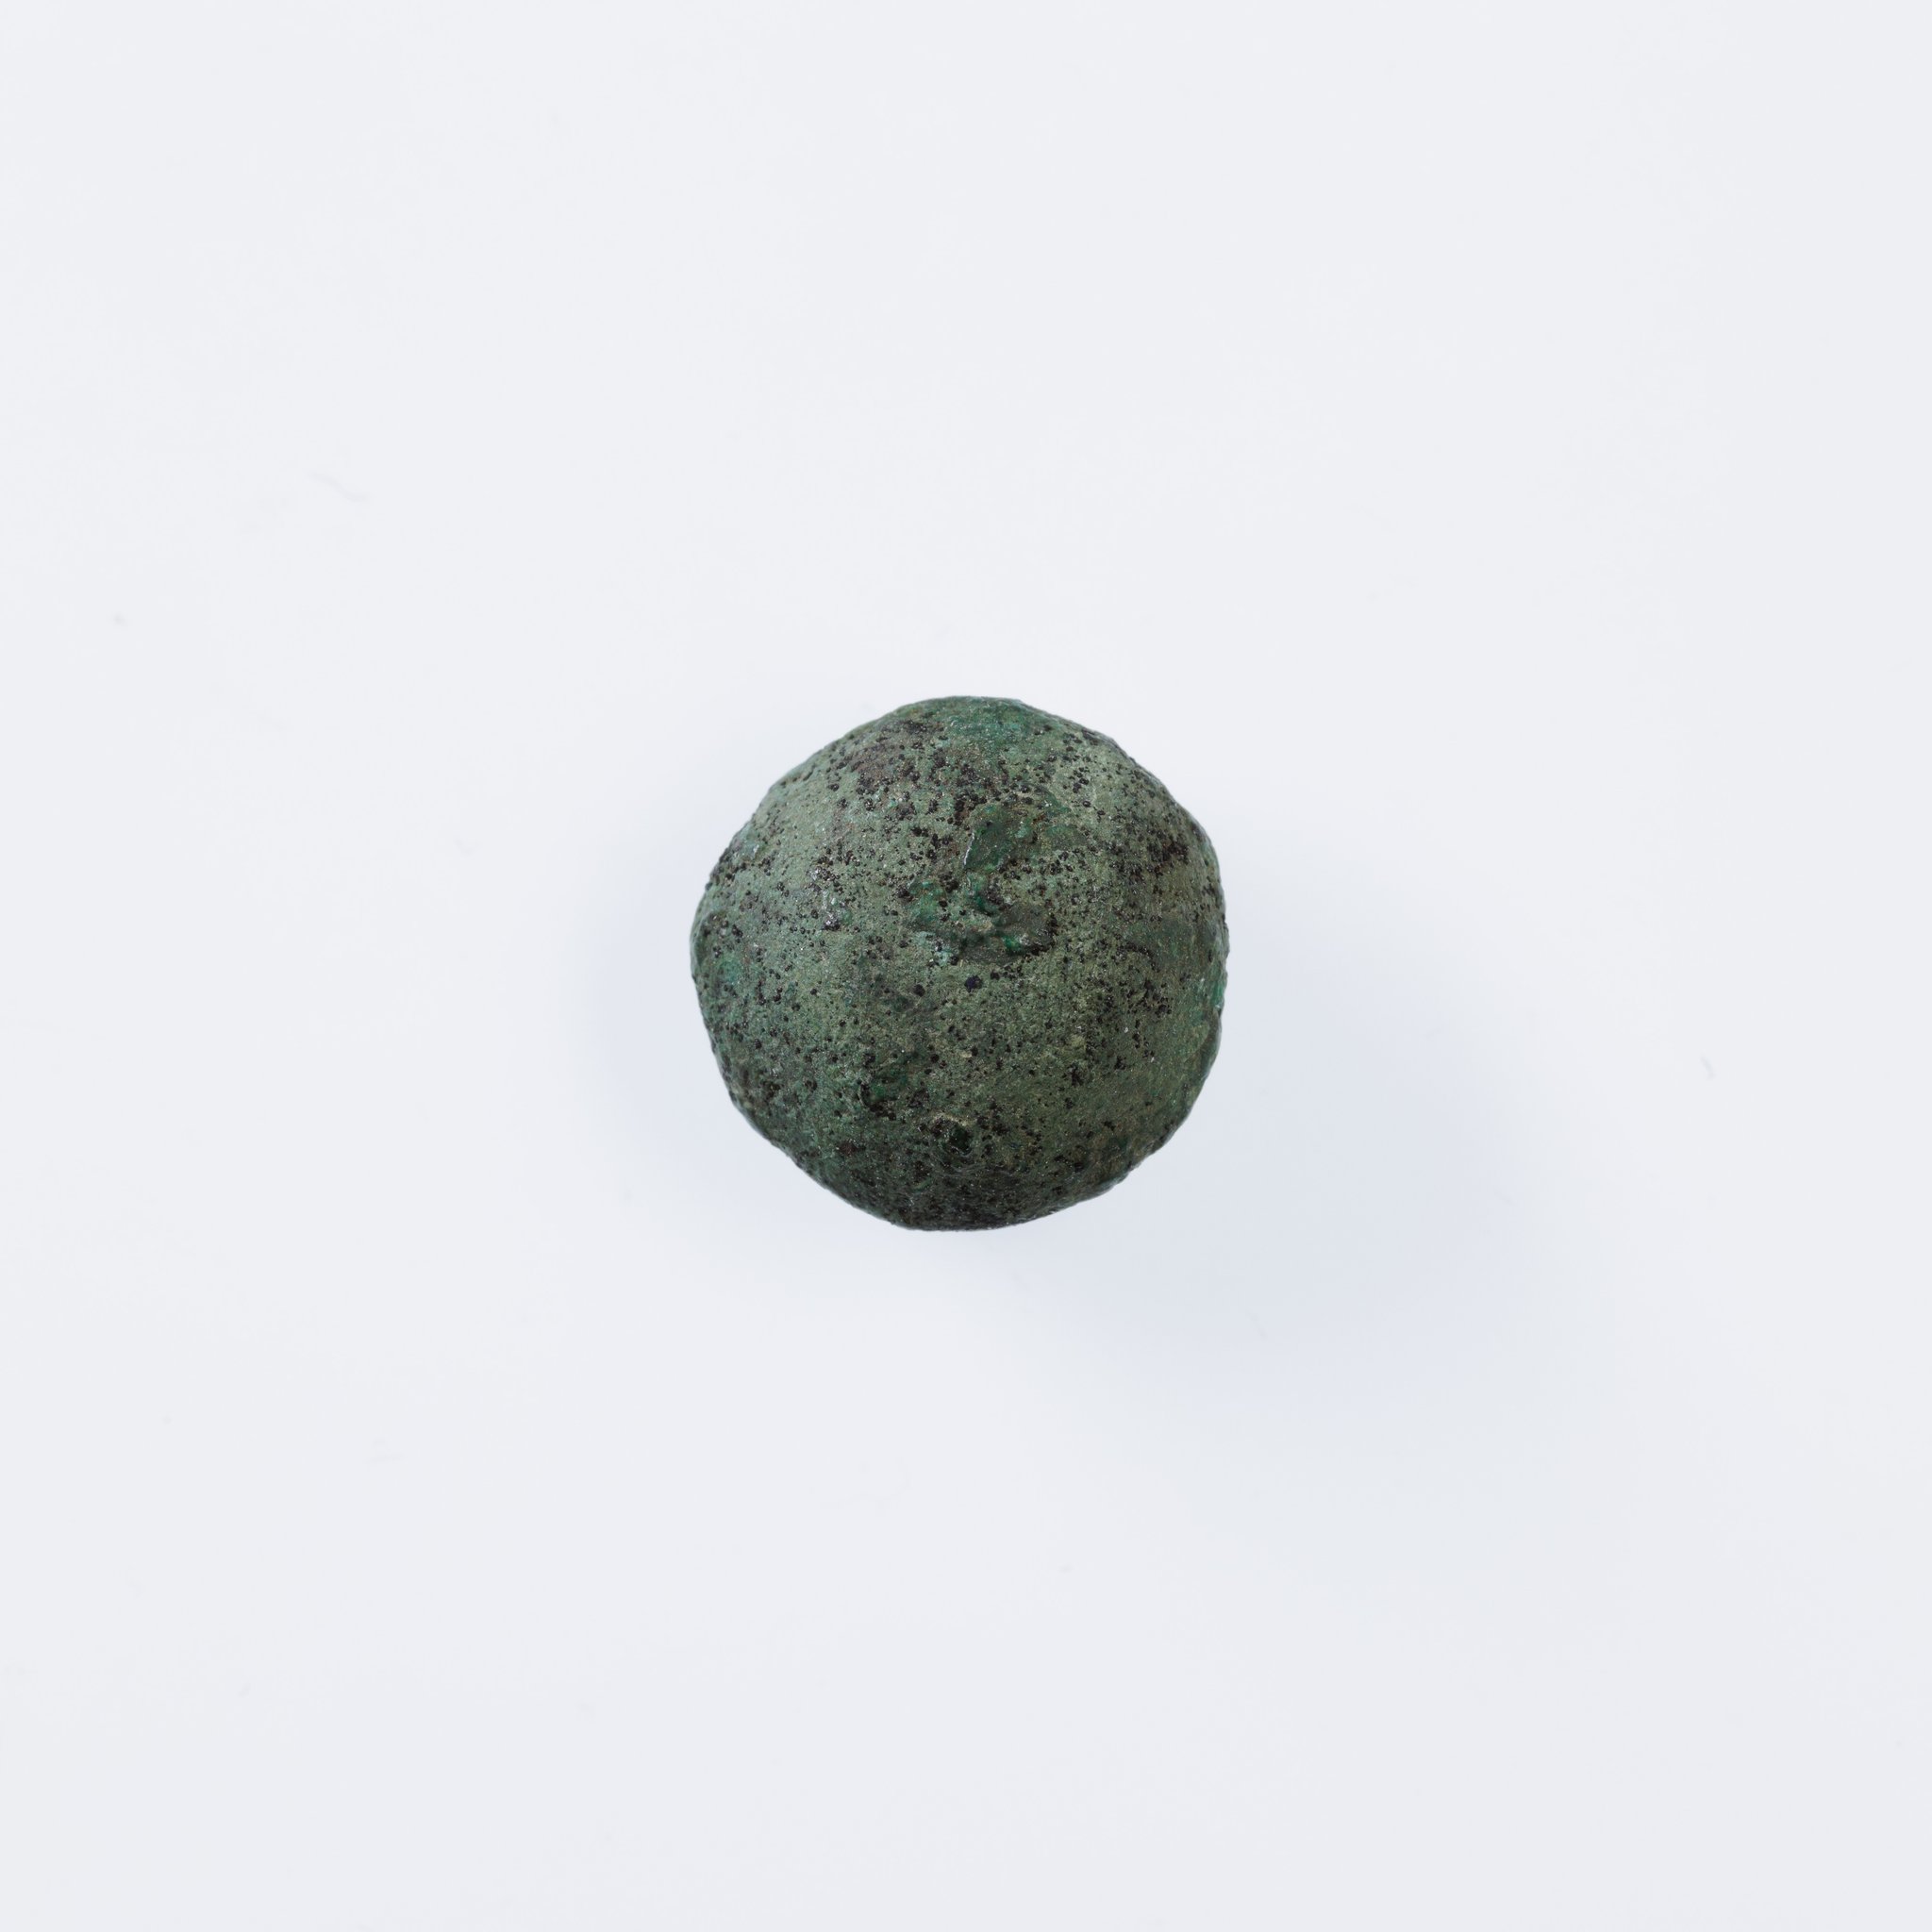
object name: weight, 1 4 kedet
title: Weight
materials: copper alloy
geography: egypt